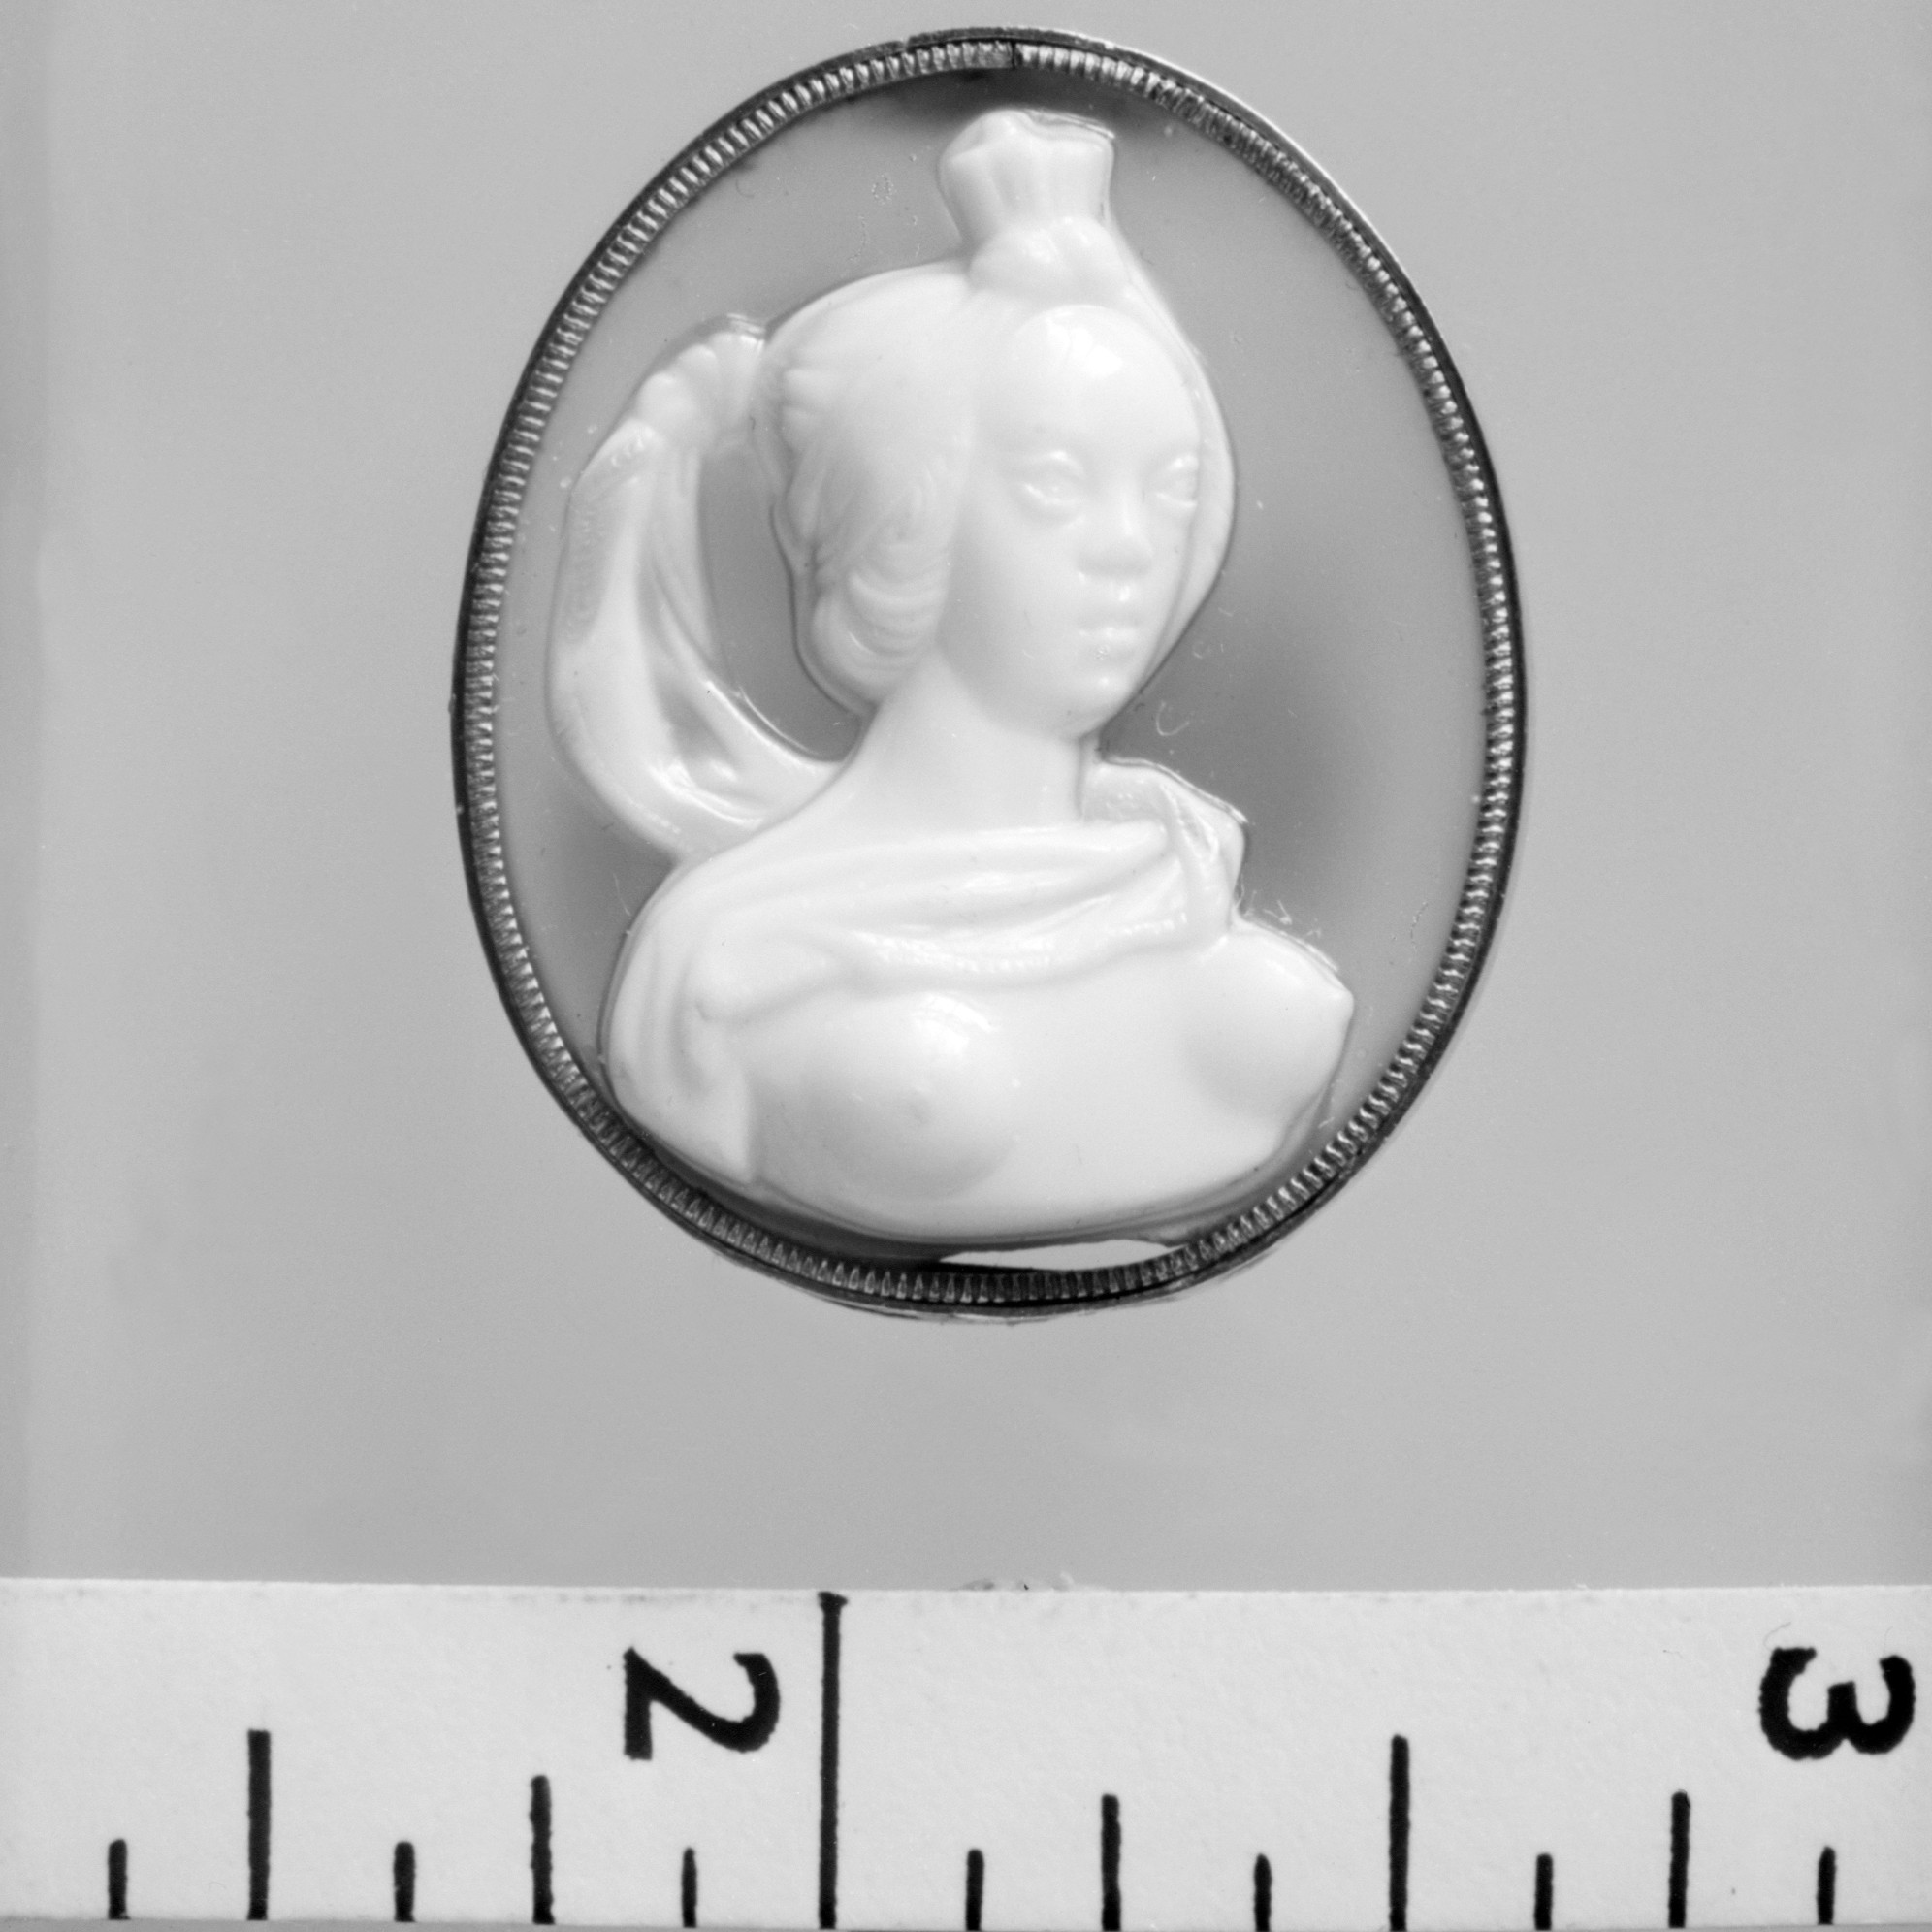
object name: cameo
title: Bust of a woman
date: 1801-1900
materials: onyx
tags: portraits,women,female nudes